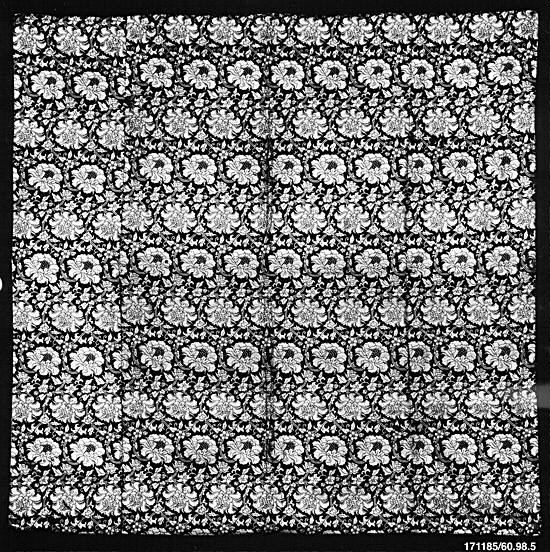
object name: altar cloth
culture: japanese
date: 1701-1800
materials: metal thread, silk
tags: flowers